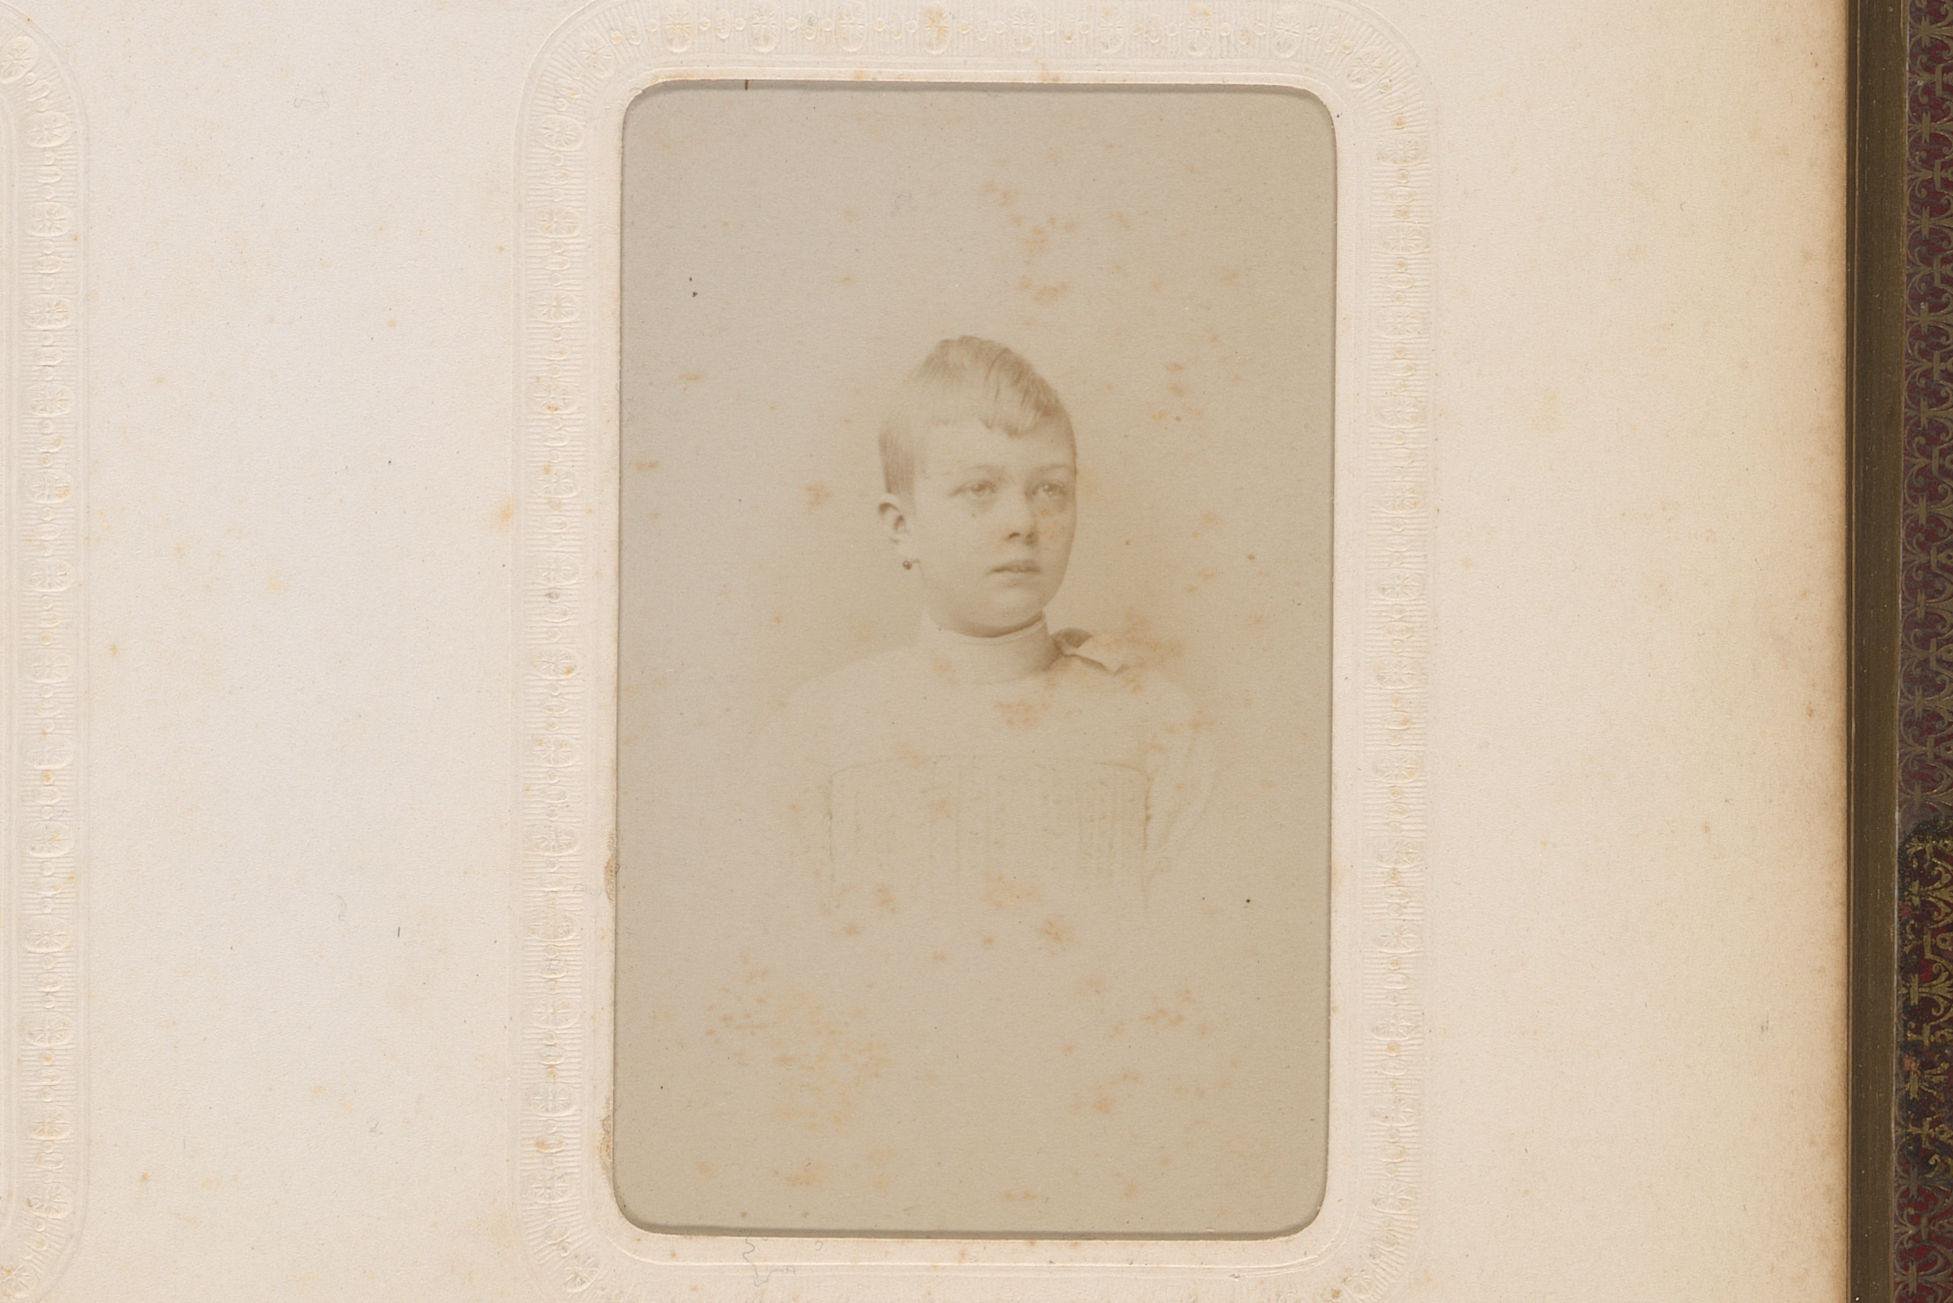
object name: album leaf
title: Portret van een meisje, zittend aan een tafel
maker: Anonymous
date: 1860-1900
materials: cardboard, photographic support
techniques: albumen print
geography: netherlands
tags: sitting figure - aa - female human figure, historical persons - bb - woman, girl (child between toddler and youth), table